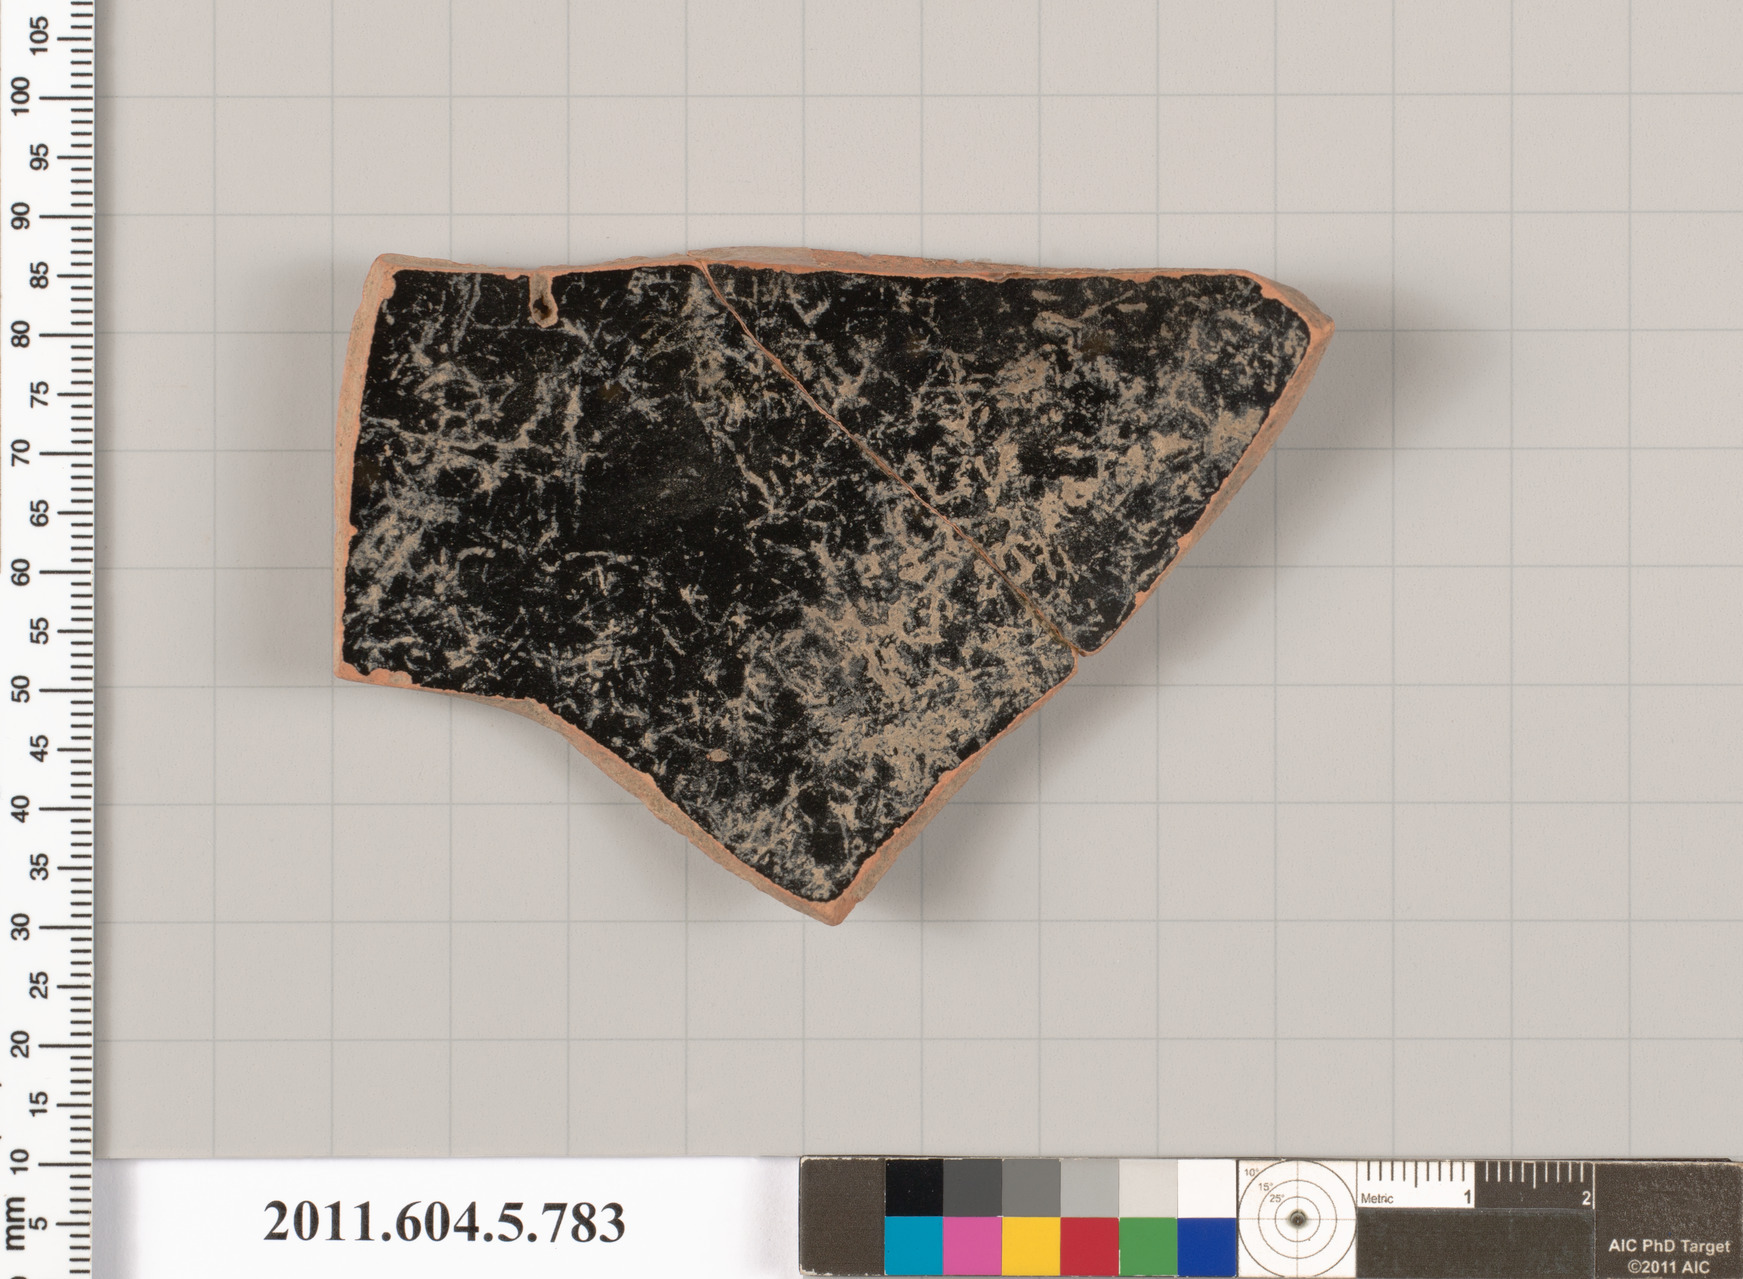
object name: kylix fragment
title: Terracotta fragment of a kylix (drinking cup)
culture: greek, attic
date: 600-401 BCE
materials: terracotta